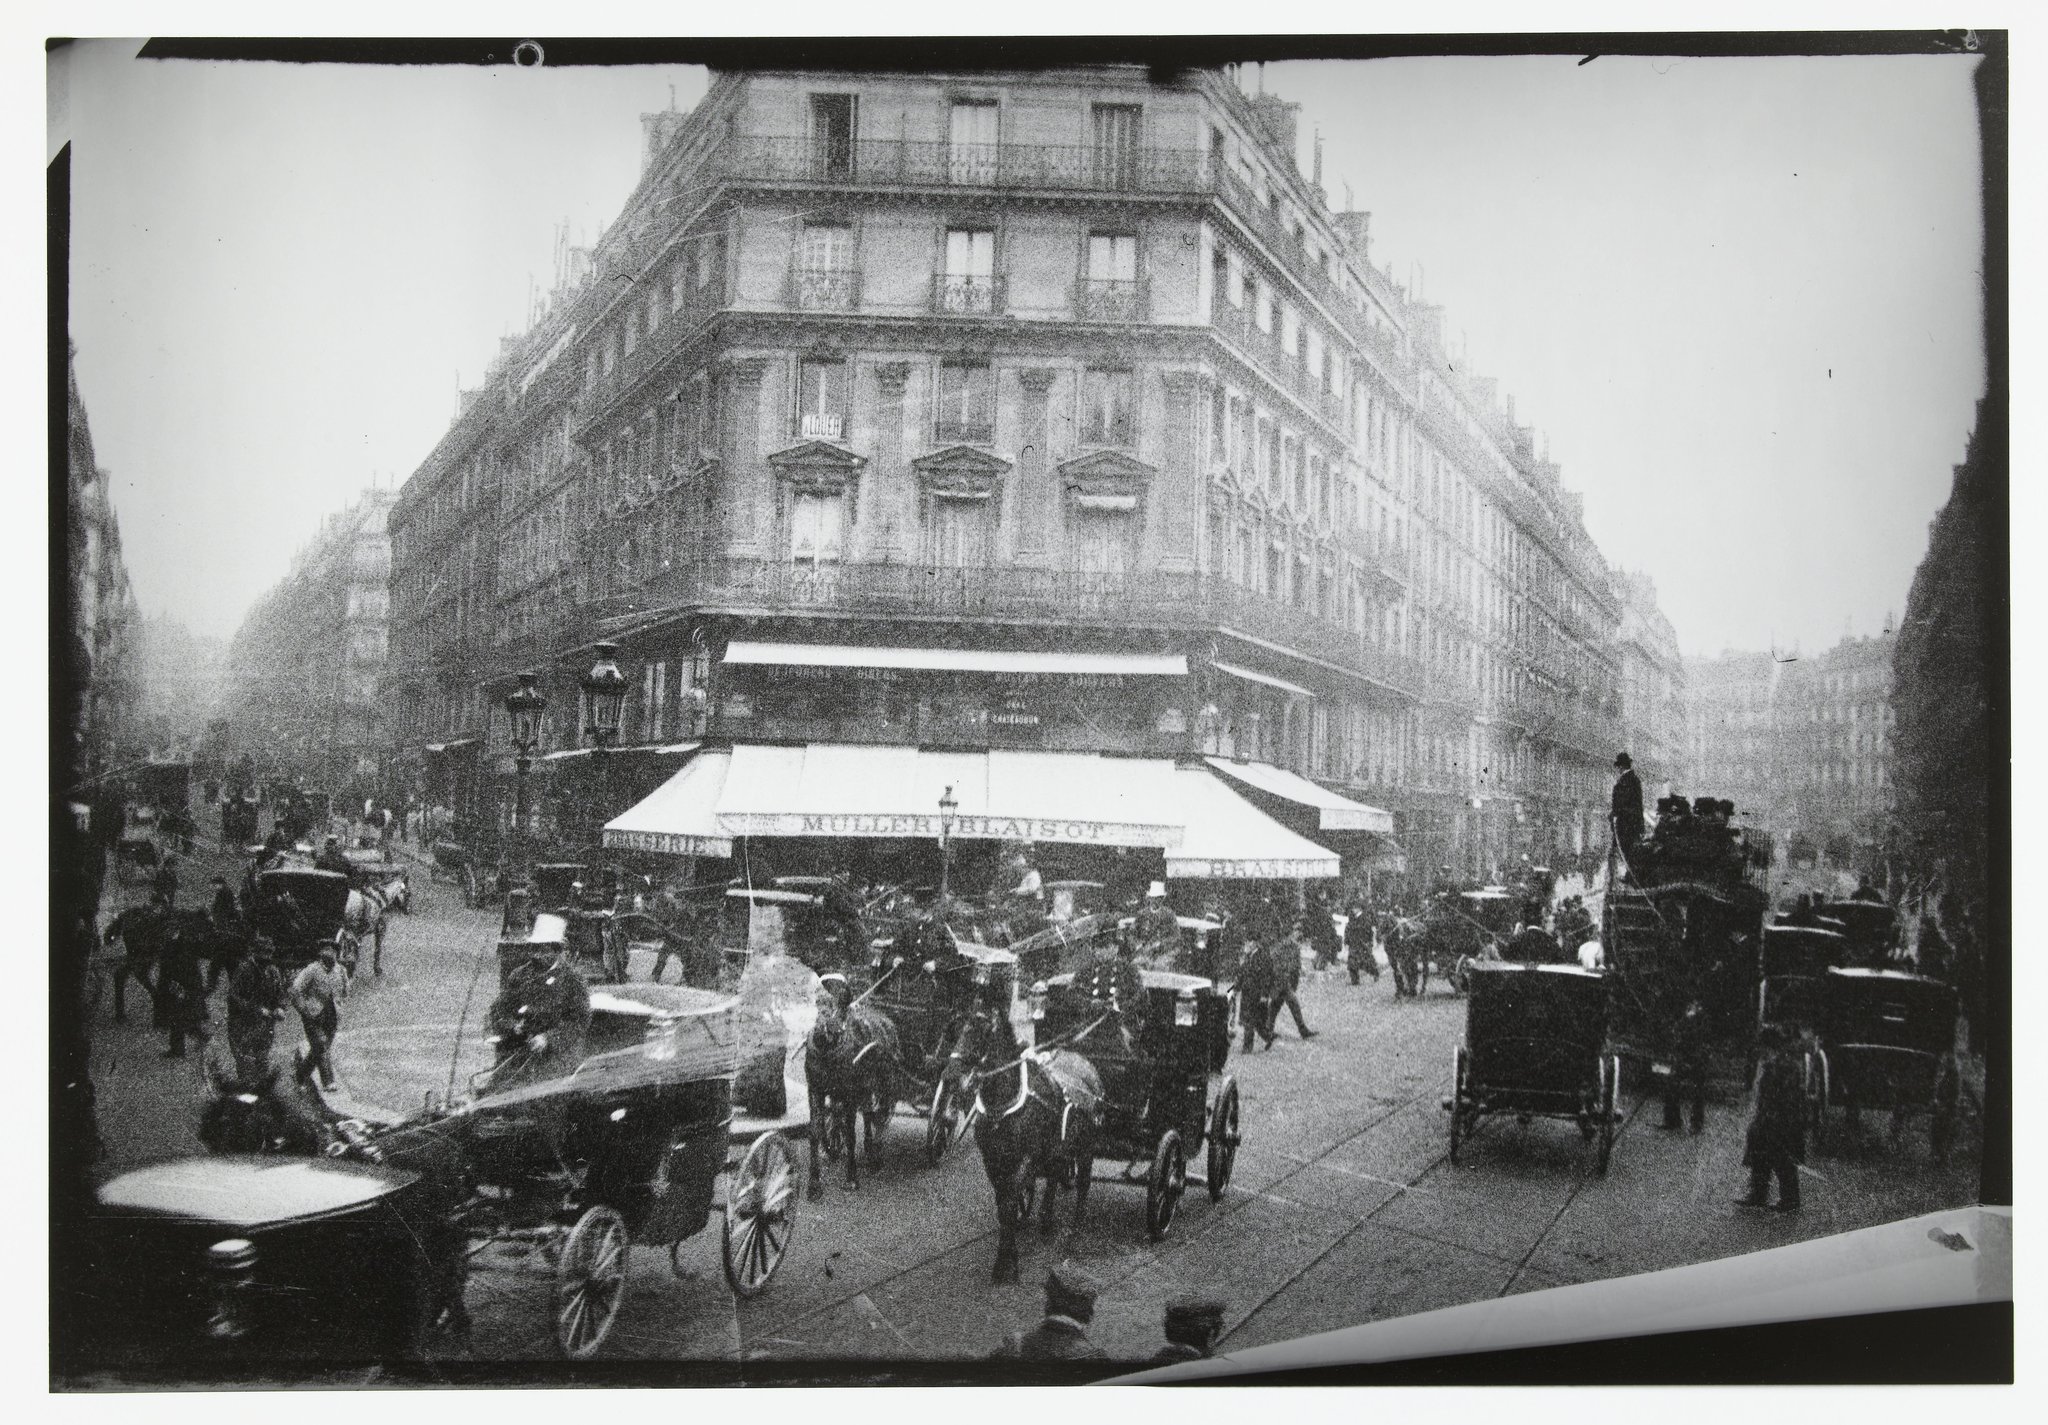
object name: photograph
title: Gezicht op brasserie Muller et Blaisot te Parijs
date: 1890-1910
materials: paper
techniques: gelatin silver print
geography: amsterdam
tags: paris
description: Gezicht op brasserie Muller et Blaisot aan de Rue Faubourg Montmartre 60 te Parijs.